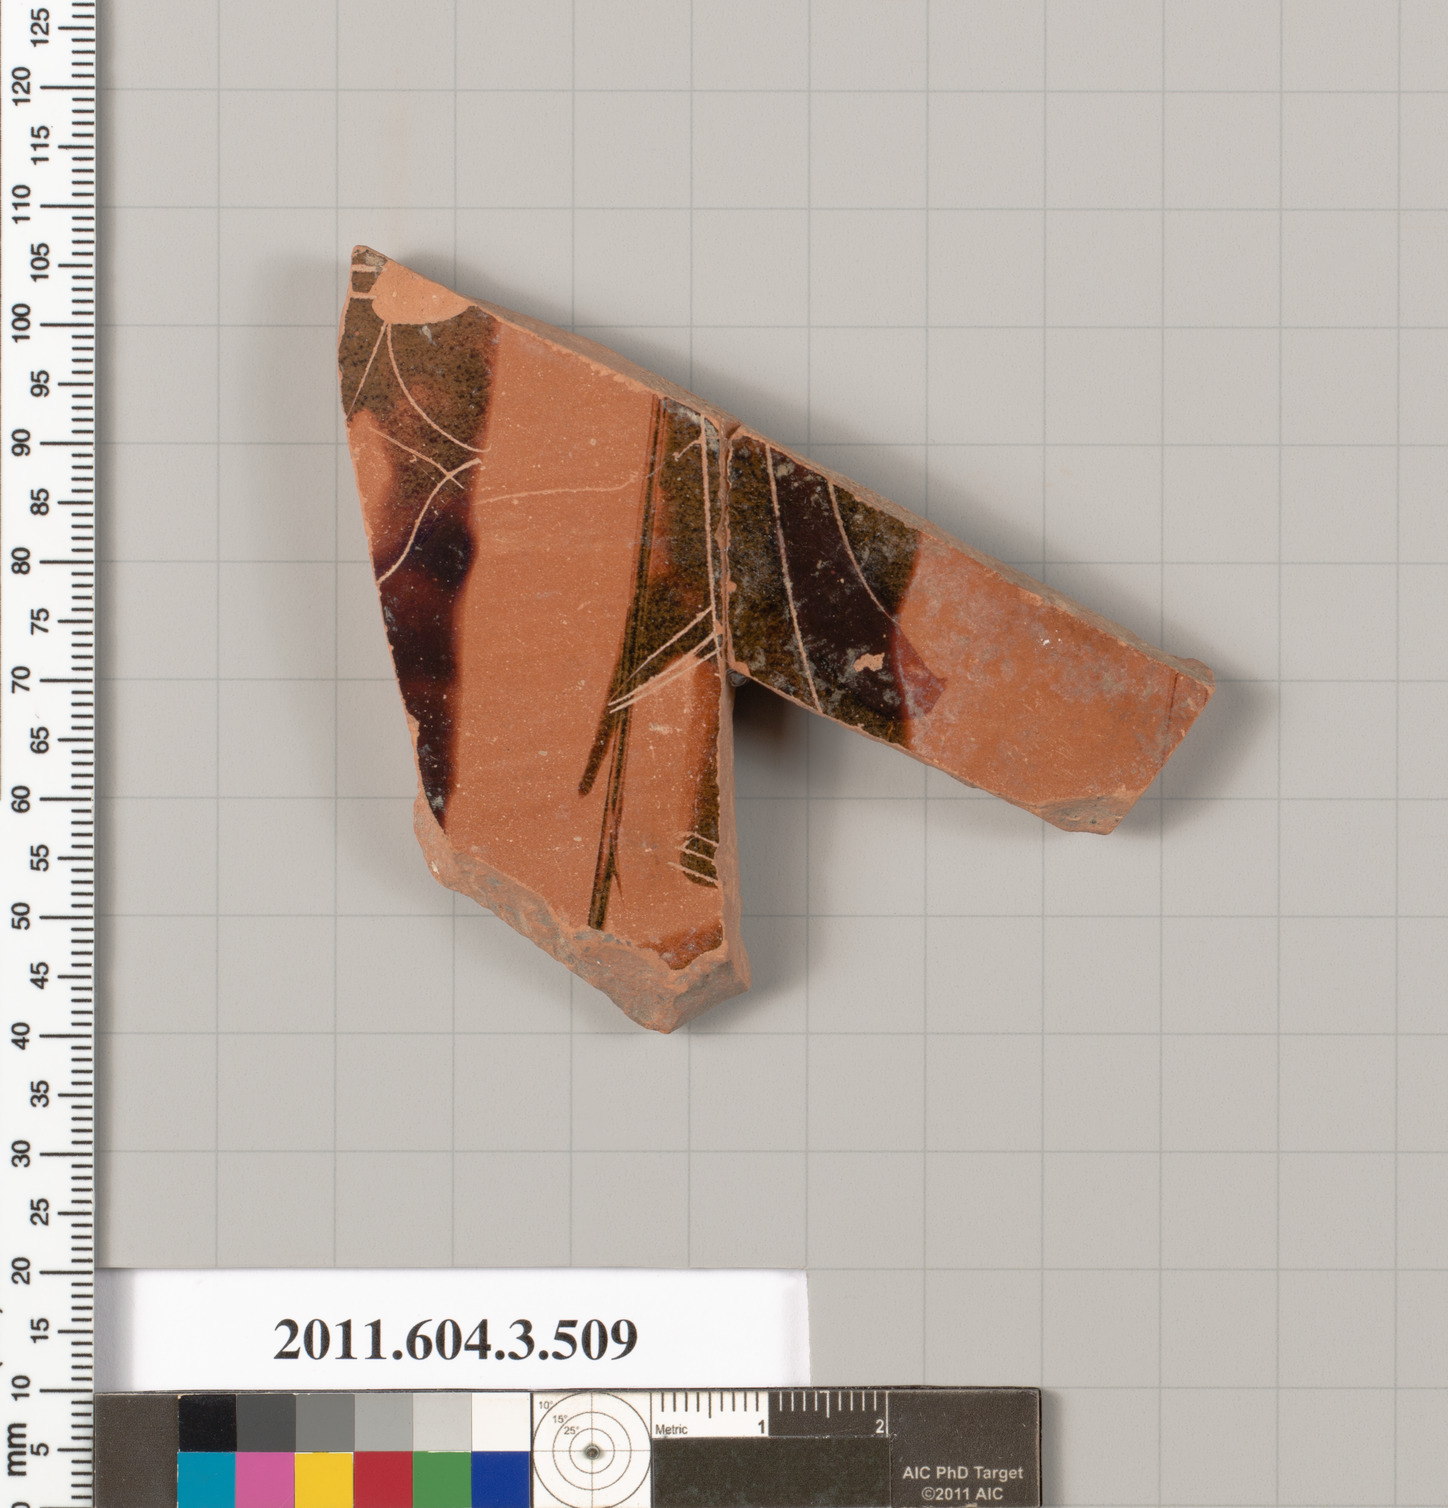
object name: column krater fragment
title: Terracotta fragment of a column-krater (bowl for mixing wine and water)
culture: greek, attic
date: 525-501 BCE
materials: terracotta